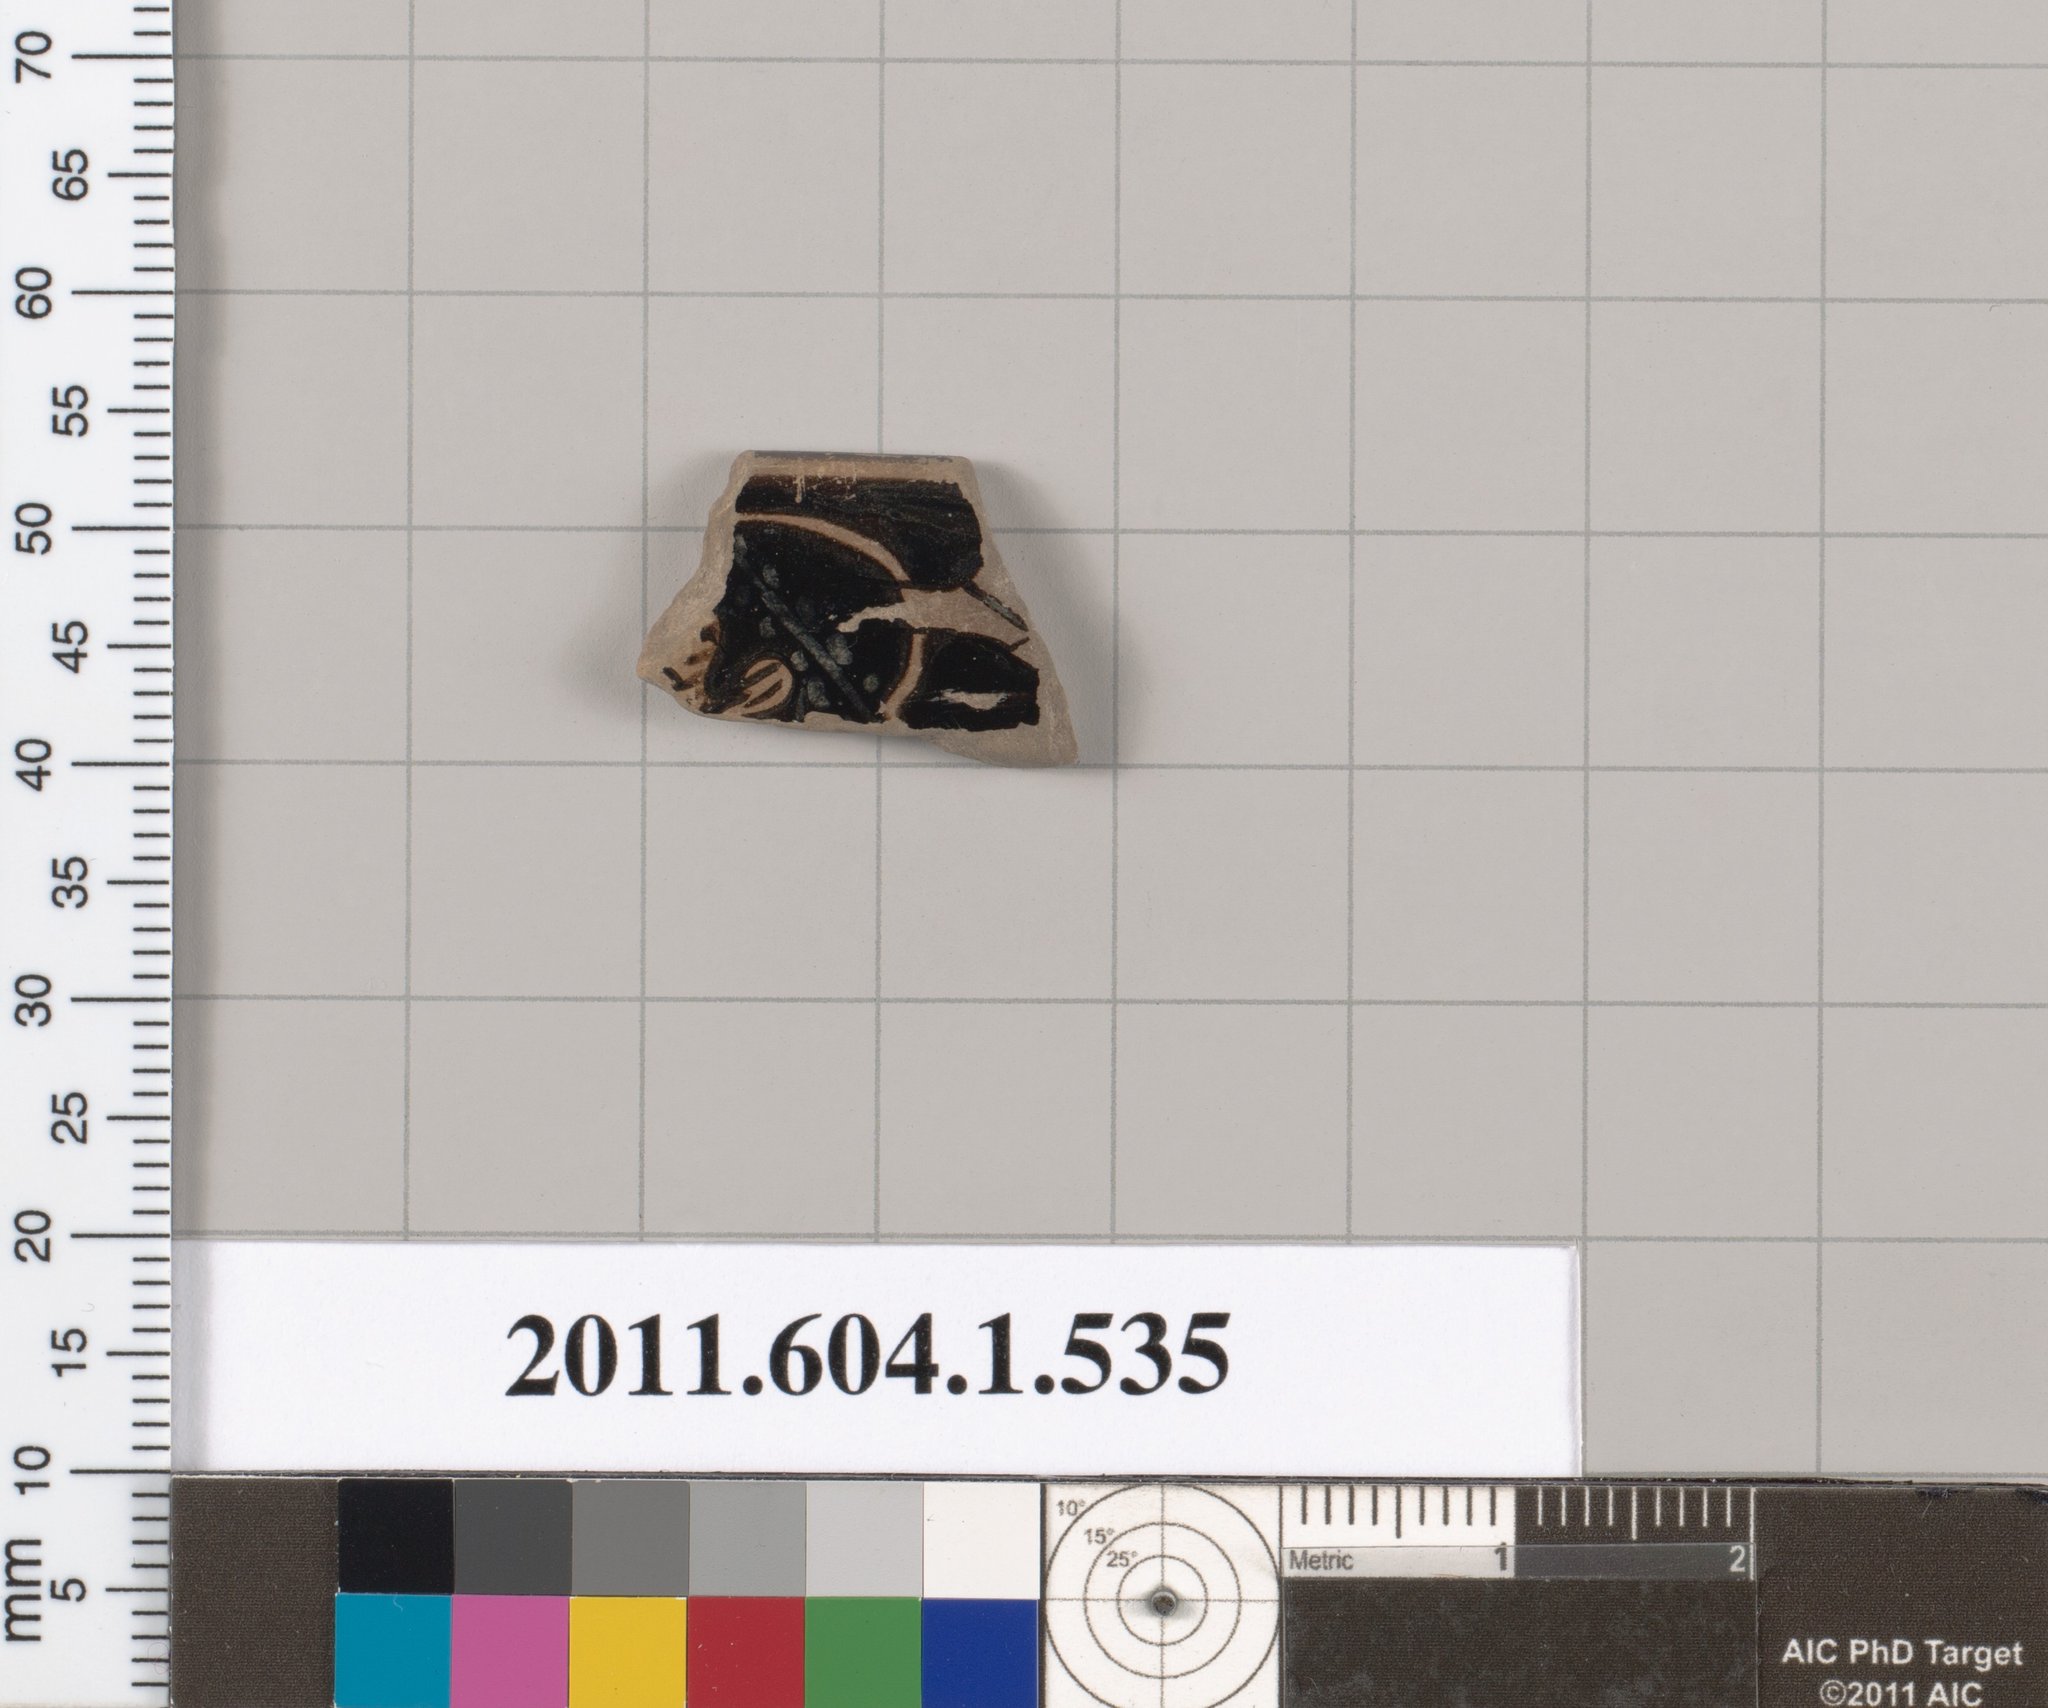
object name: kylix fragment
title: Terracotta rim fragment of a kylix (drinking cup)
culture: greek, attic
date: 480-470 BCE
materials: terracotta